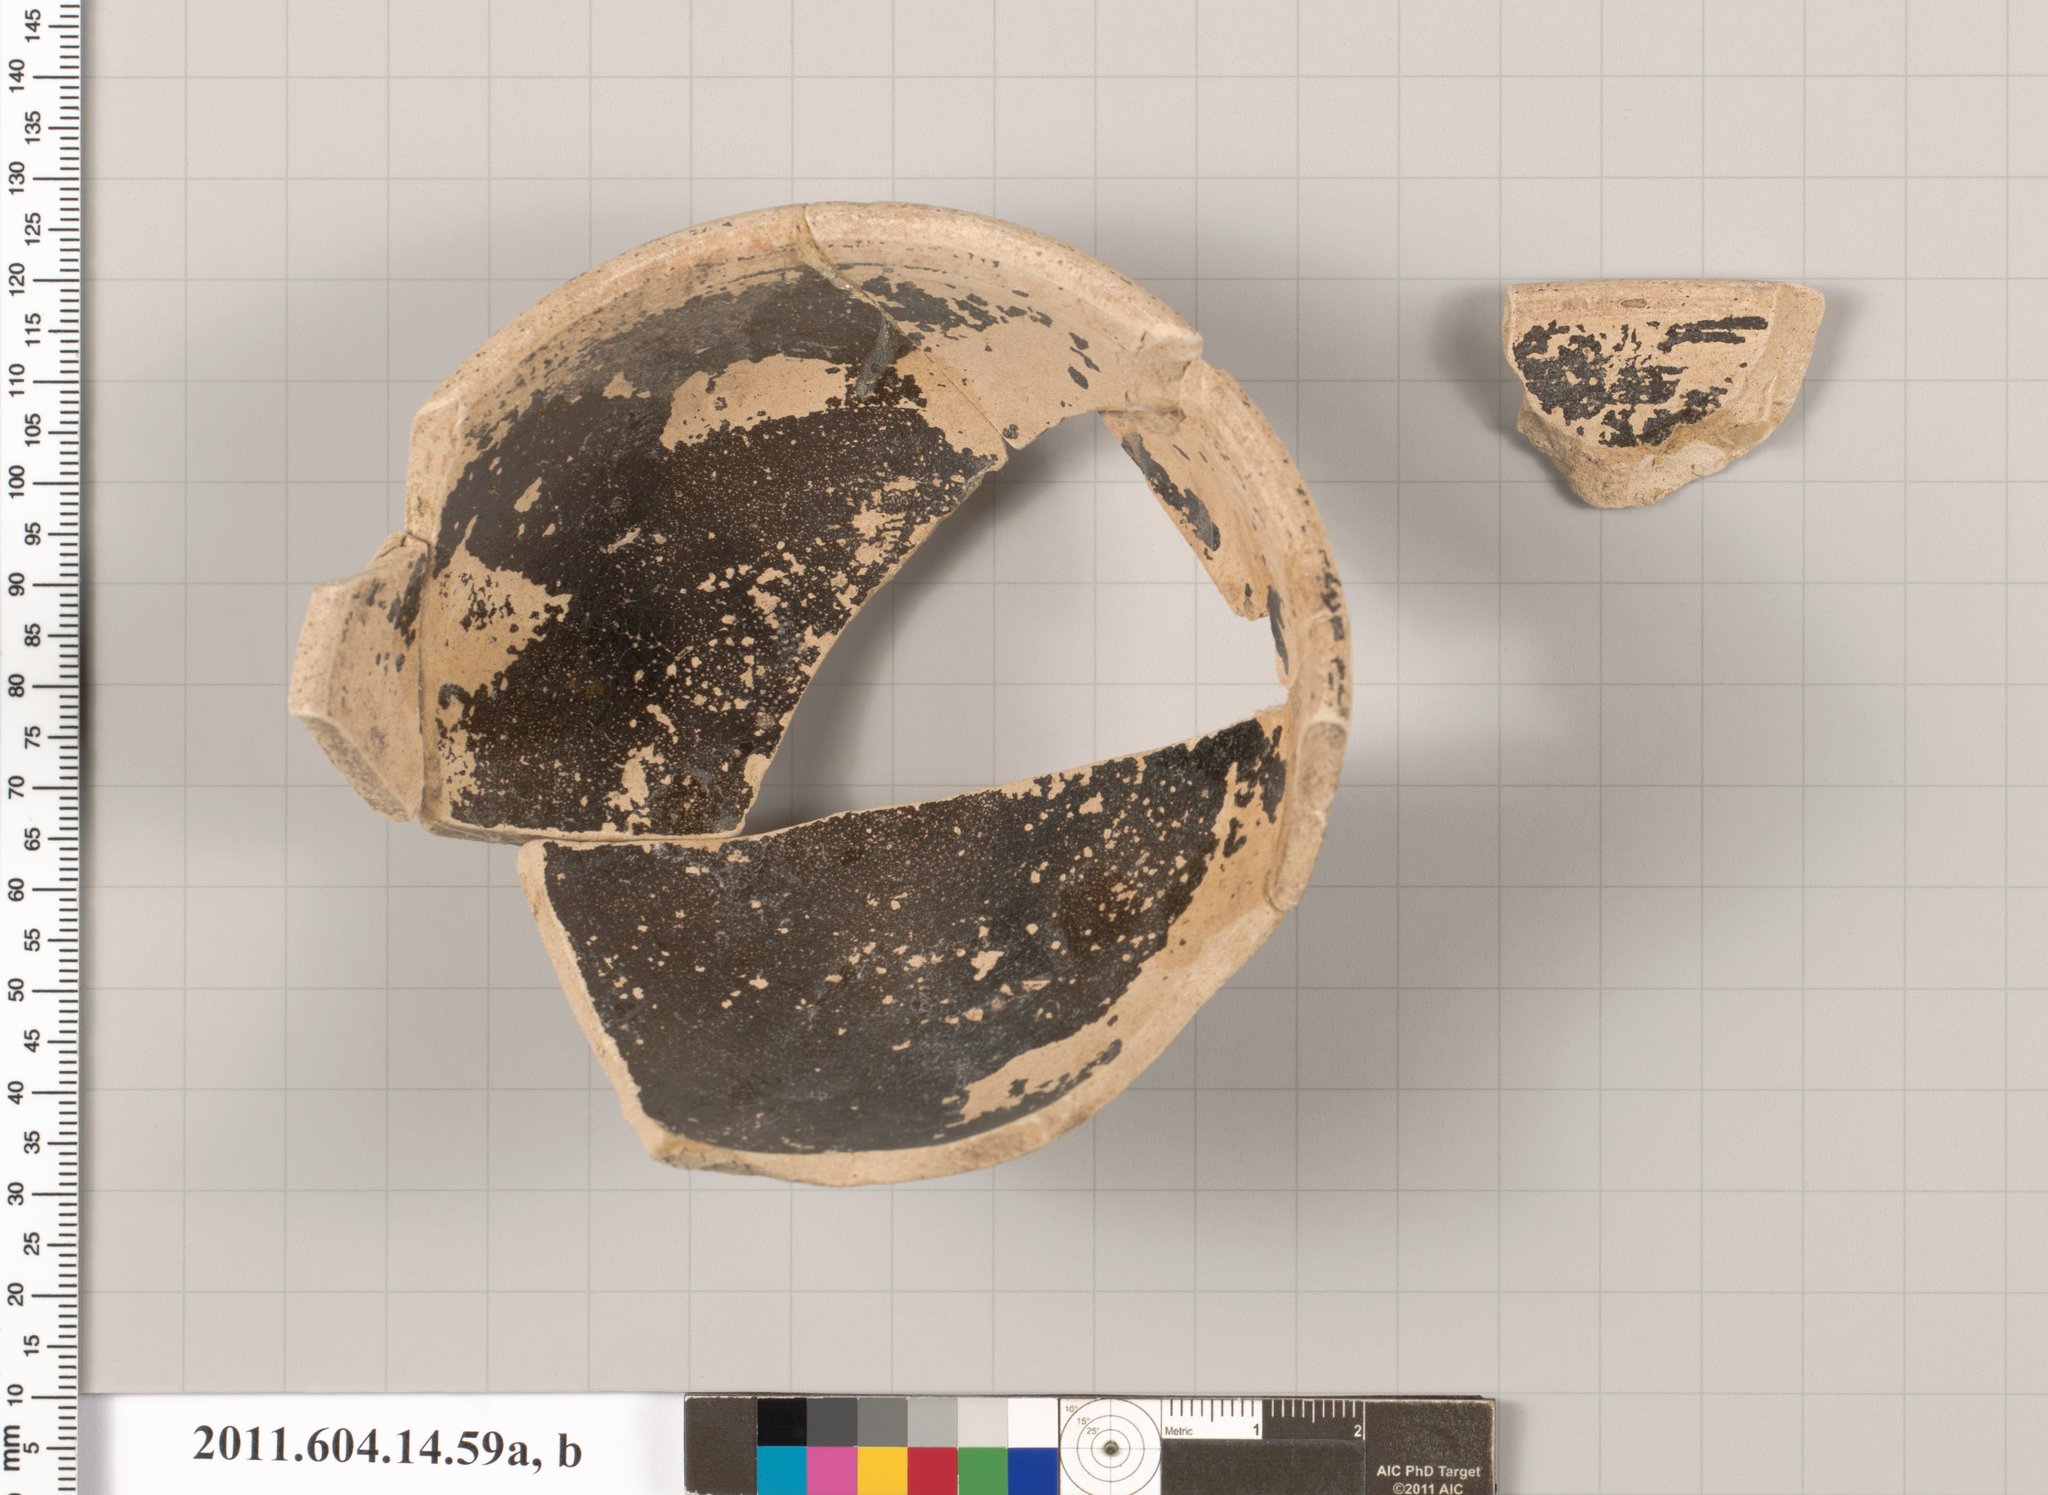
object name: fragment of a bowl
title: Terracotta fragments of a bowl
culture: unknown fabric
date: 600-301 BCE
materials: terracotta